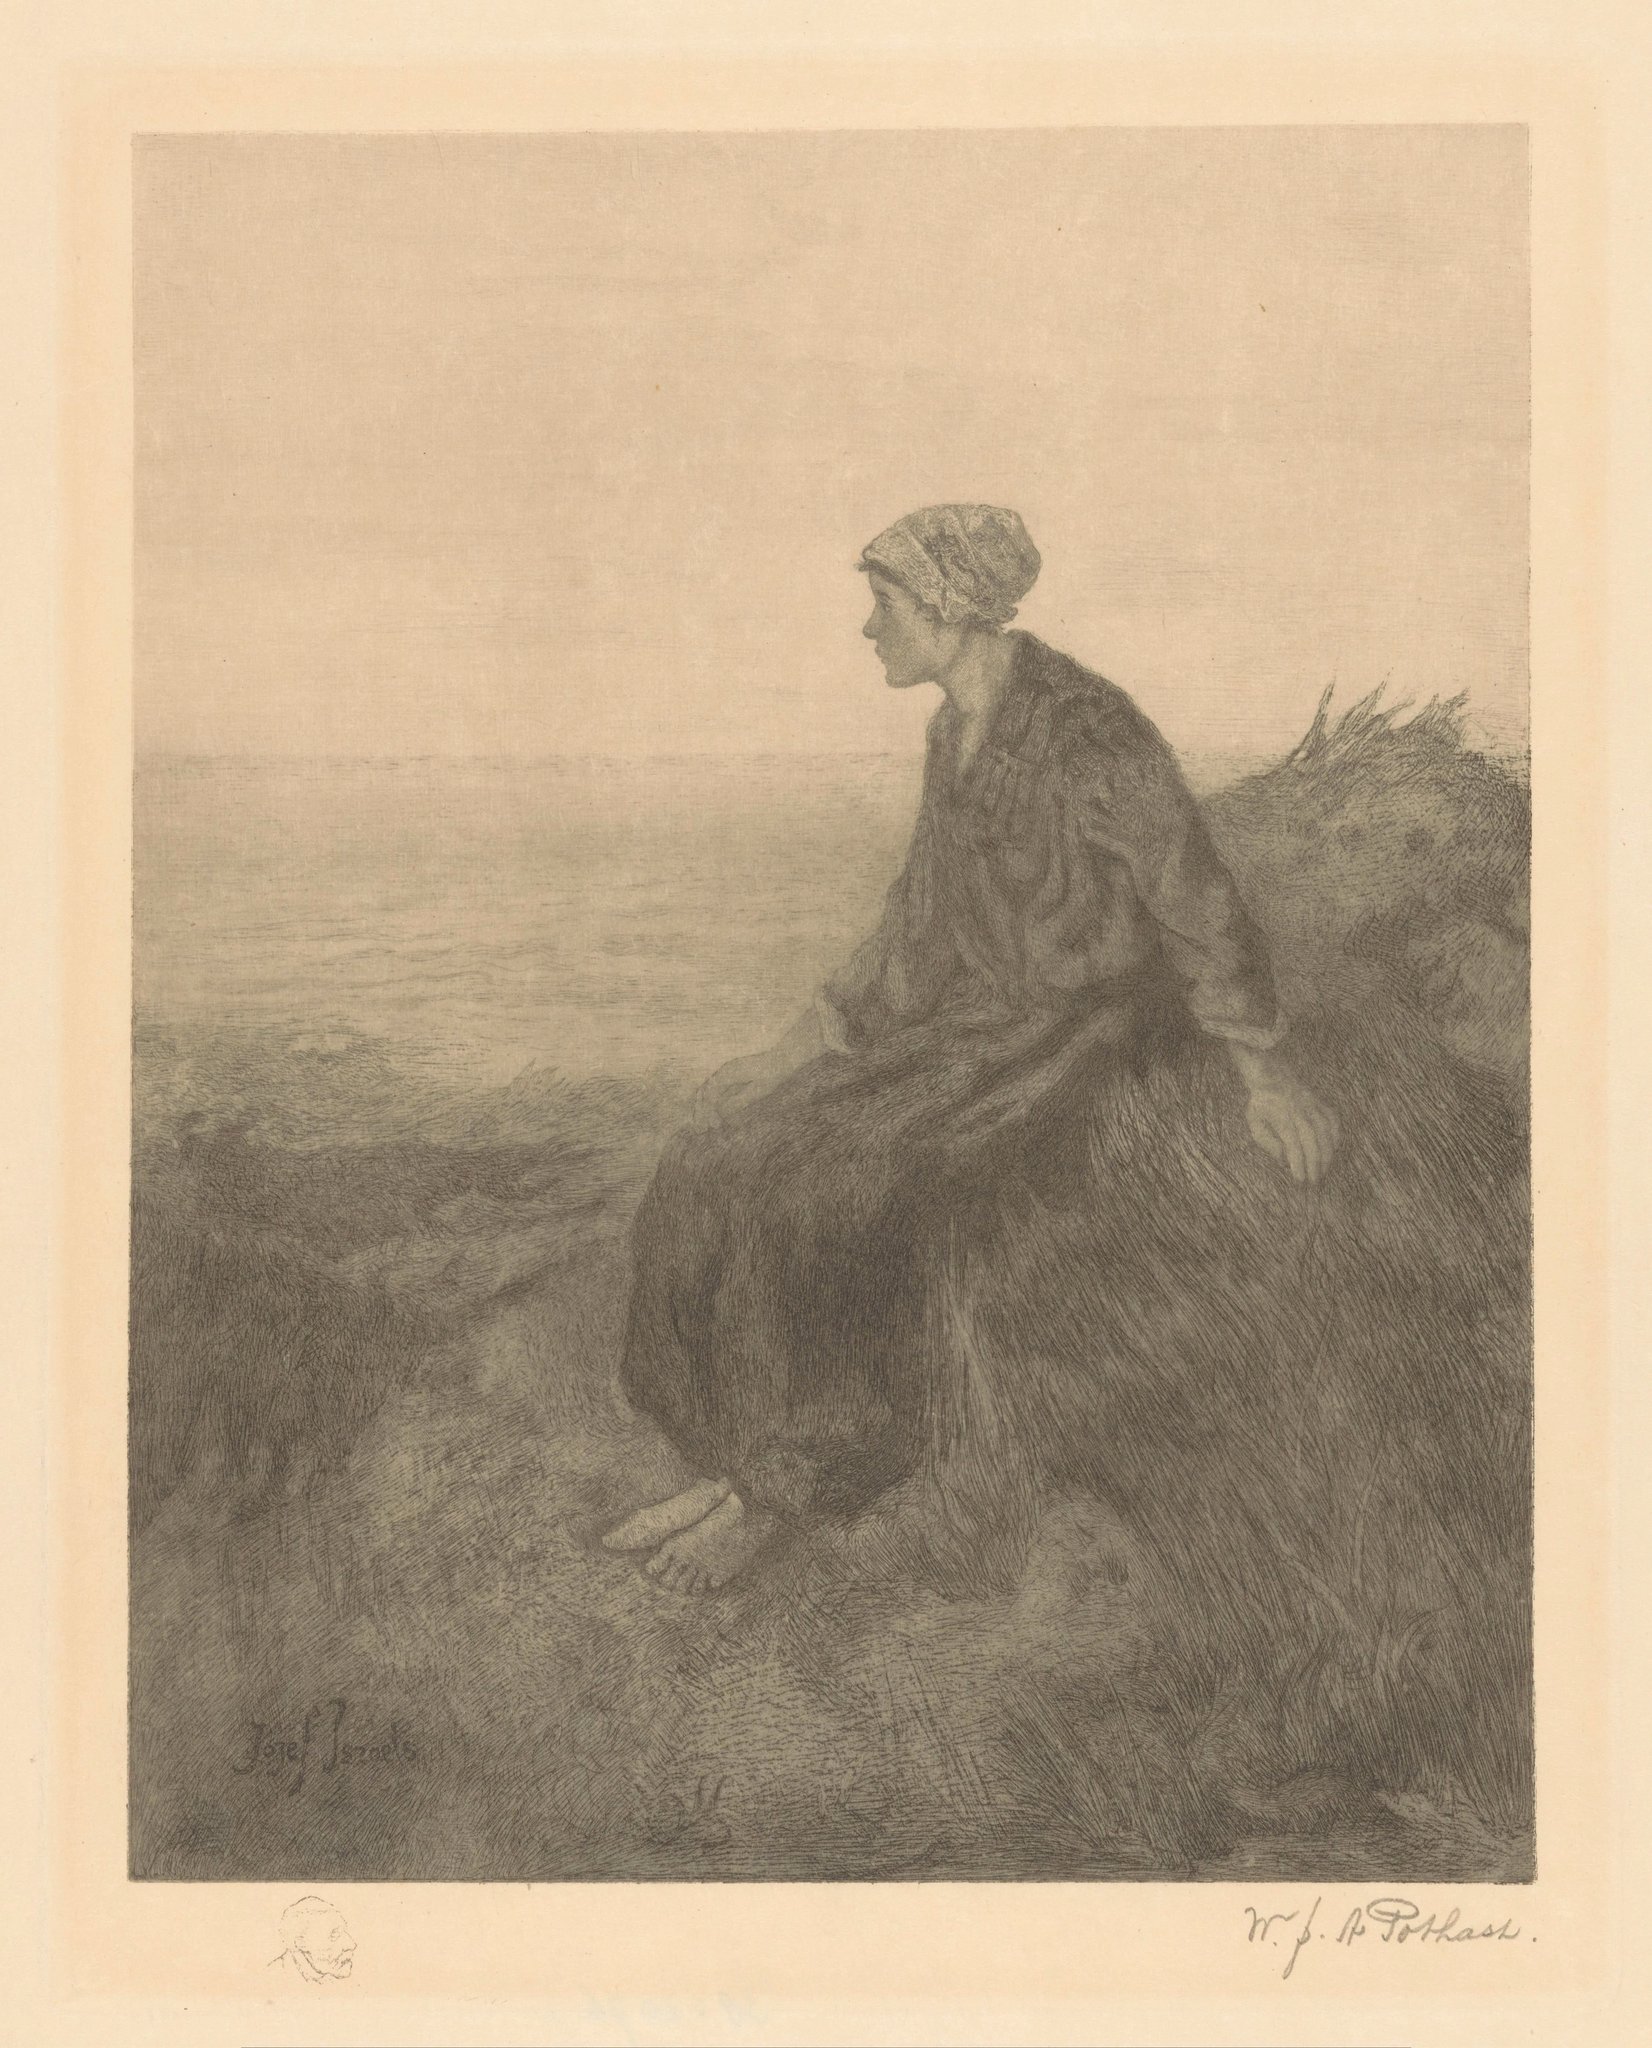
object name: print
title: Girl in the Dunes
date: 1887-1916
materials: paper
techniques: etching, intaglio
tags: adolescent, young woman, maiden, dune coast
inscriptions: stamp, collector's mark: Lugt 2166, collector's mark: Lugt 2760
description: Een meisje met blote voeten zit in de duinen uit te kijken over zee.